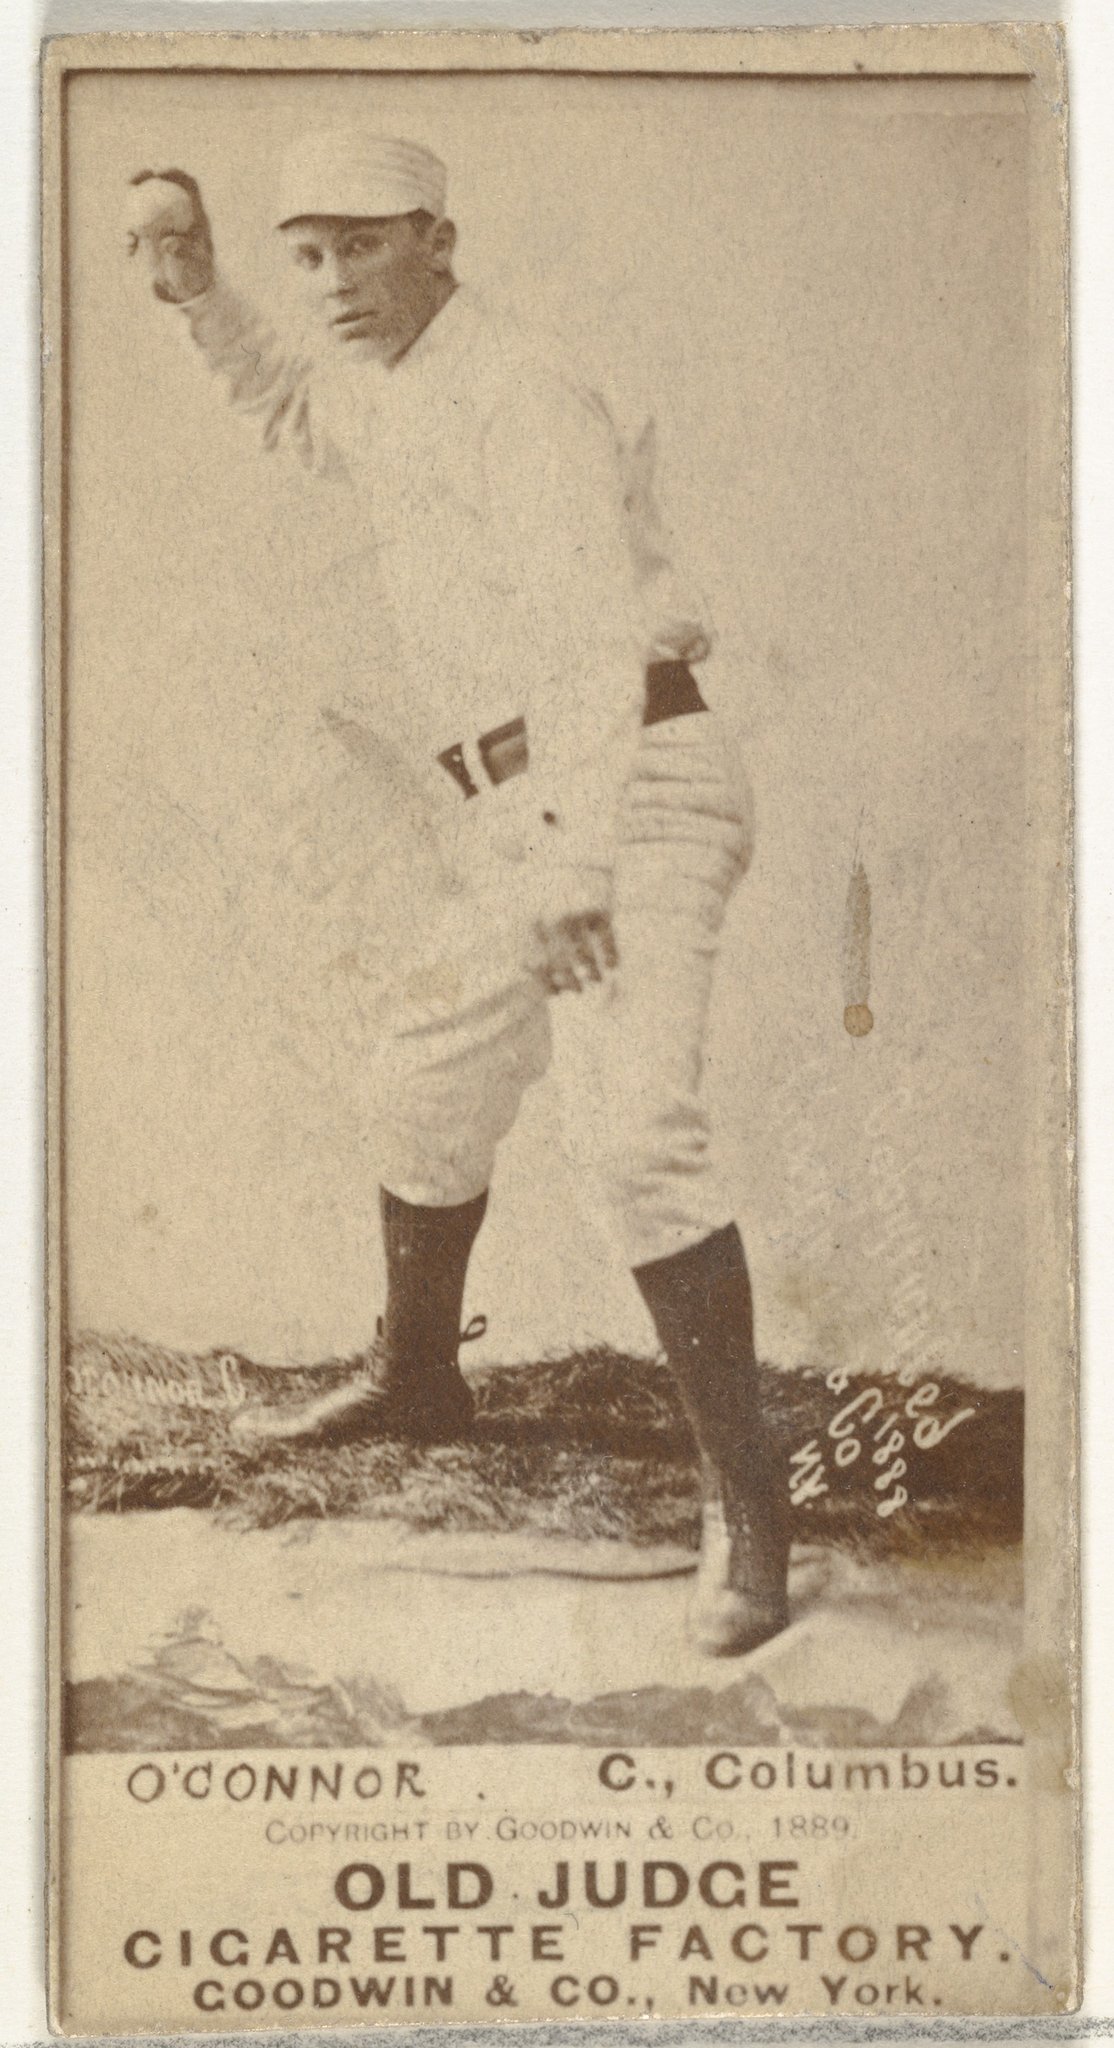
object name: baseball card, photograph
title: Jack "Peach Pie" O'Connor, Catcher, Cleveland, from the Old Judge series (N172) for Old Judge Cigarettes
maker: goodwin & company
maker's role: publisher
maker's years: 1850-1950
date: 1889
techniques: albumen silver print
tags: men,baseball,athletes